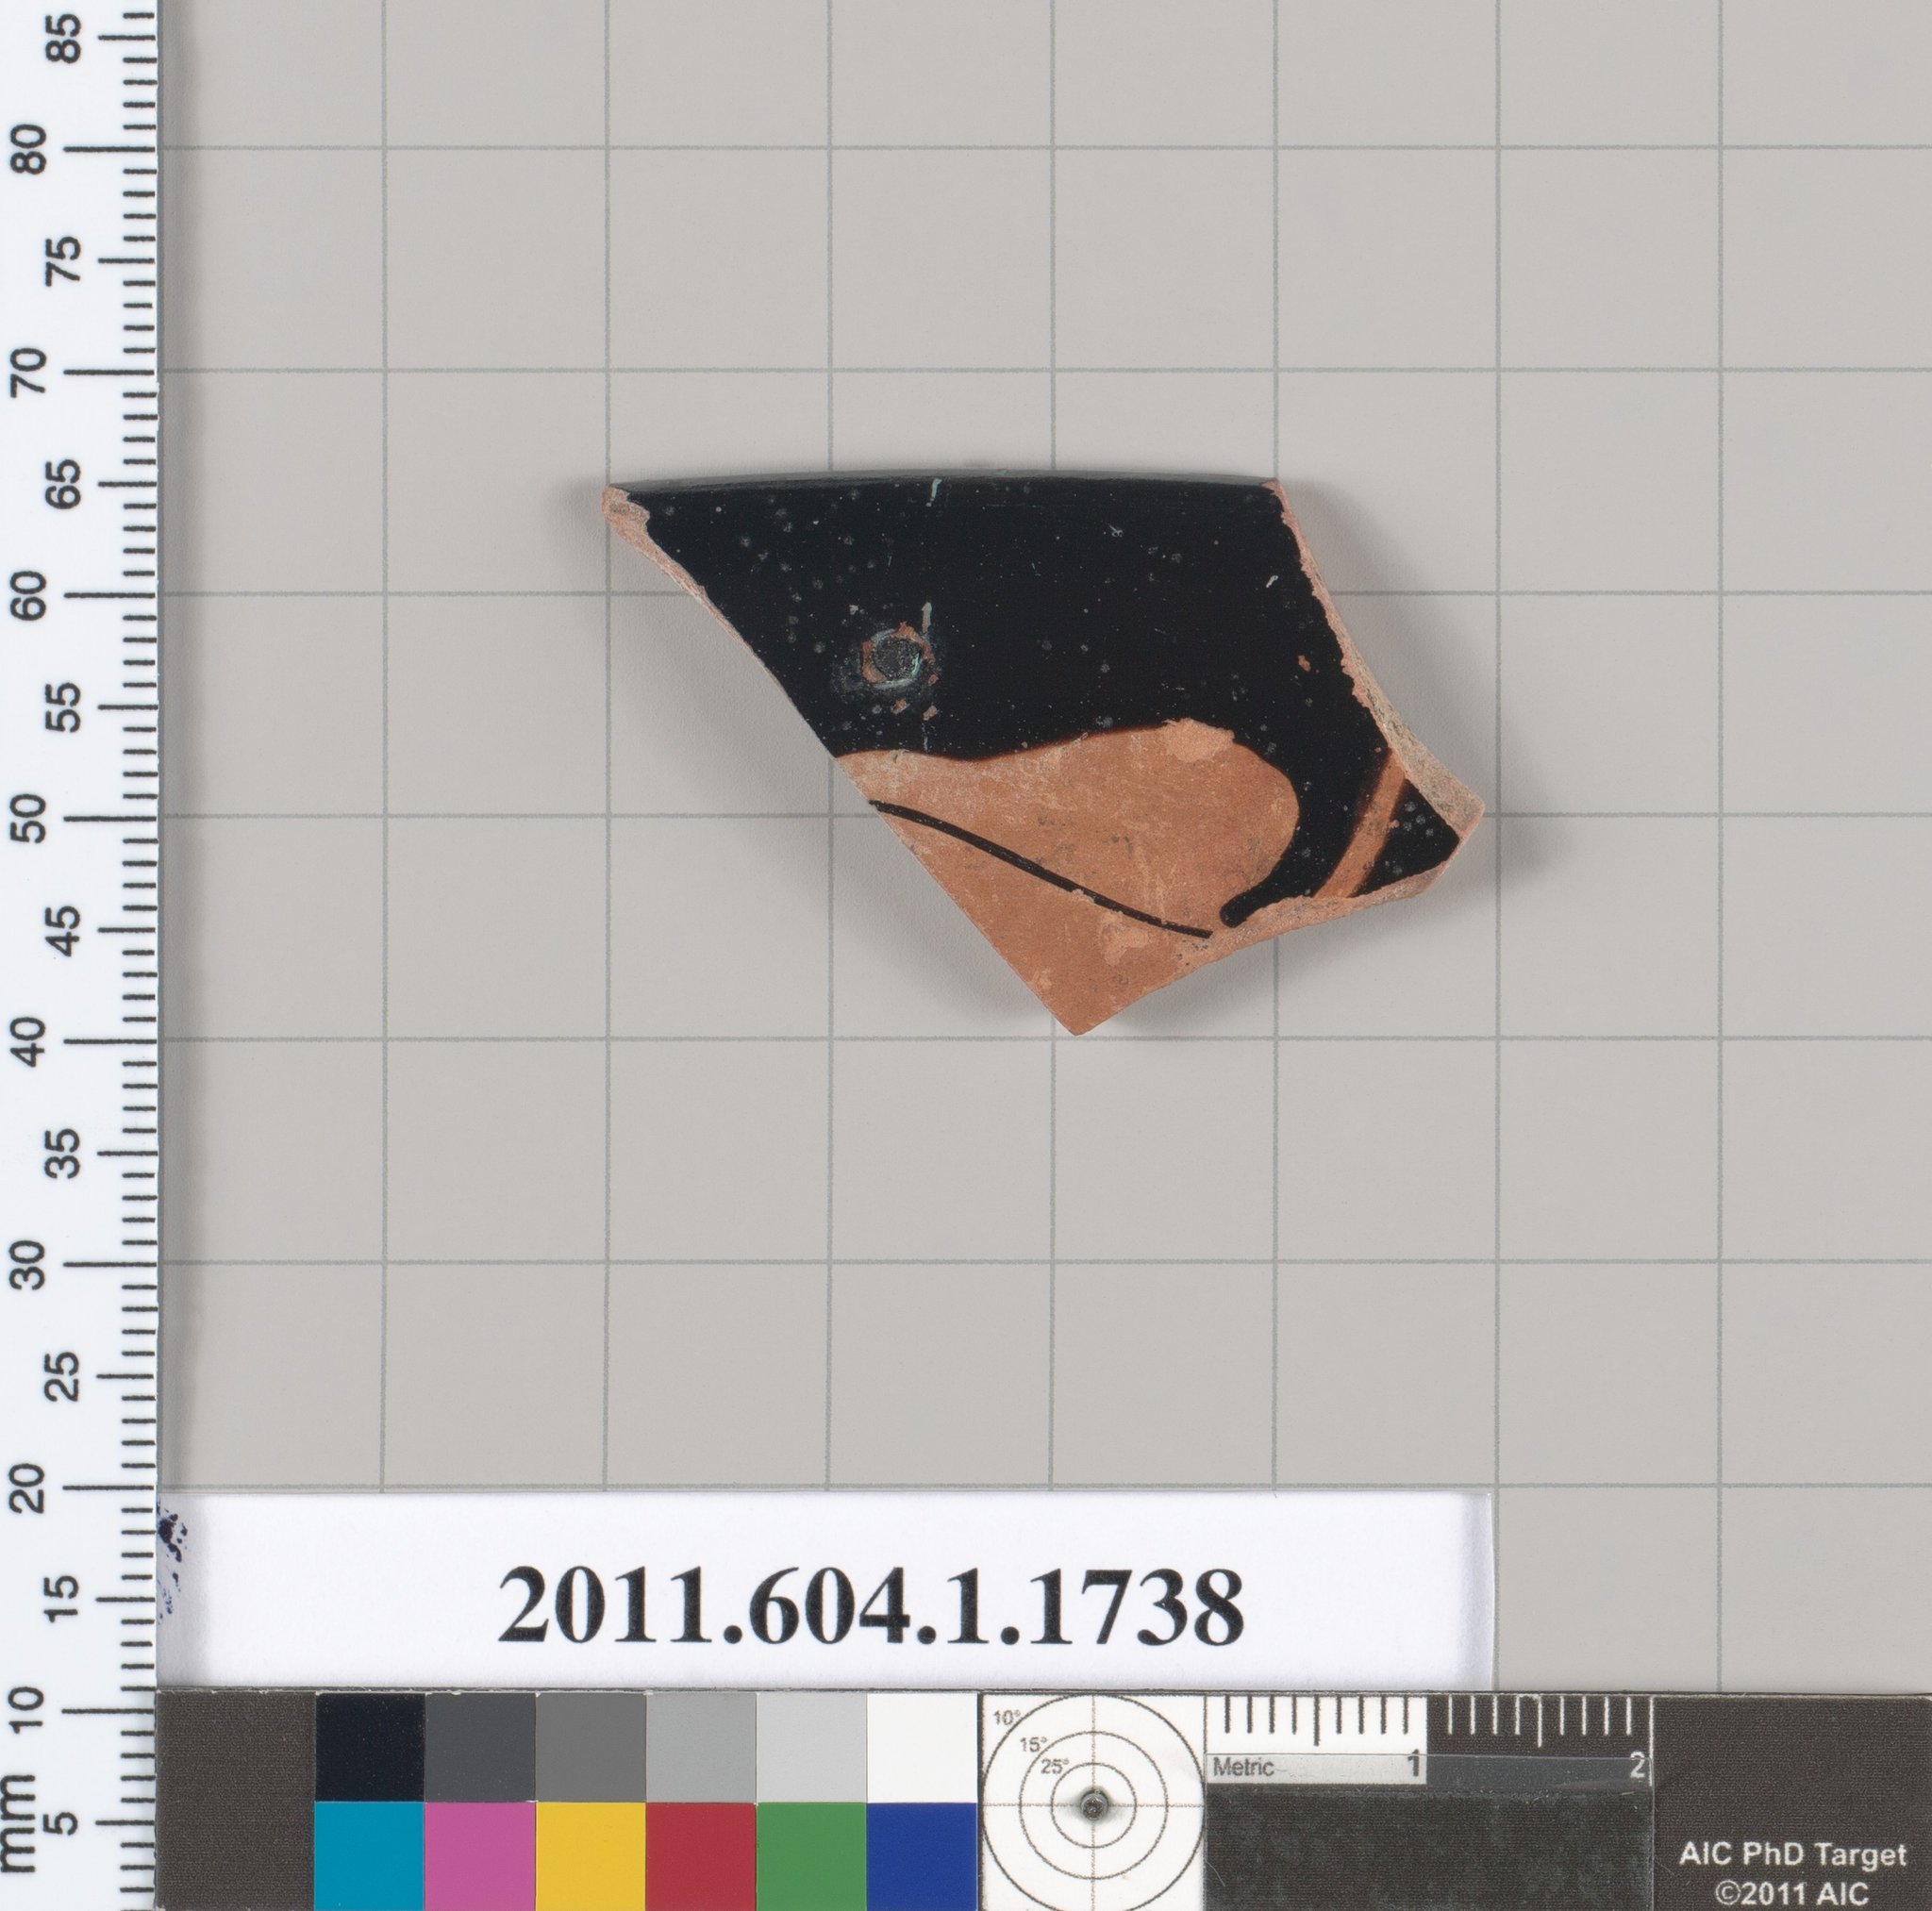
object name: kylix fragment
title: Terracotta rim fragment of a kylix (drinking cup)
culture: greek, attic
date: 475-451 BCE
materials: terracotta